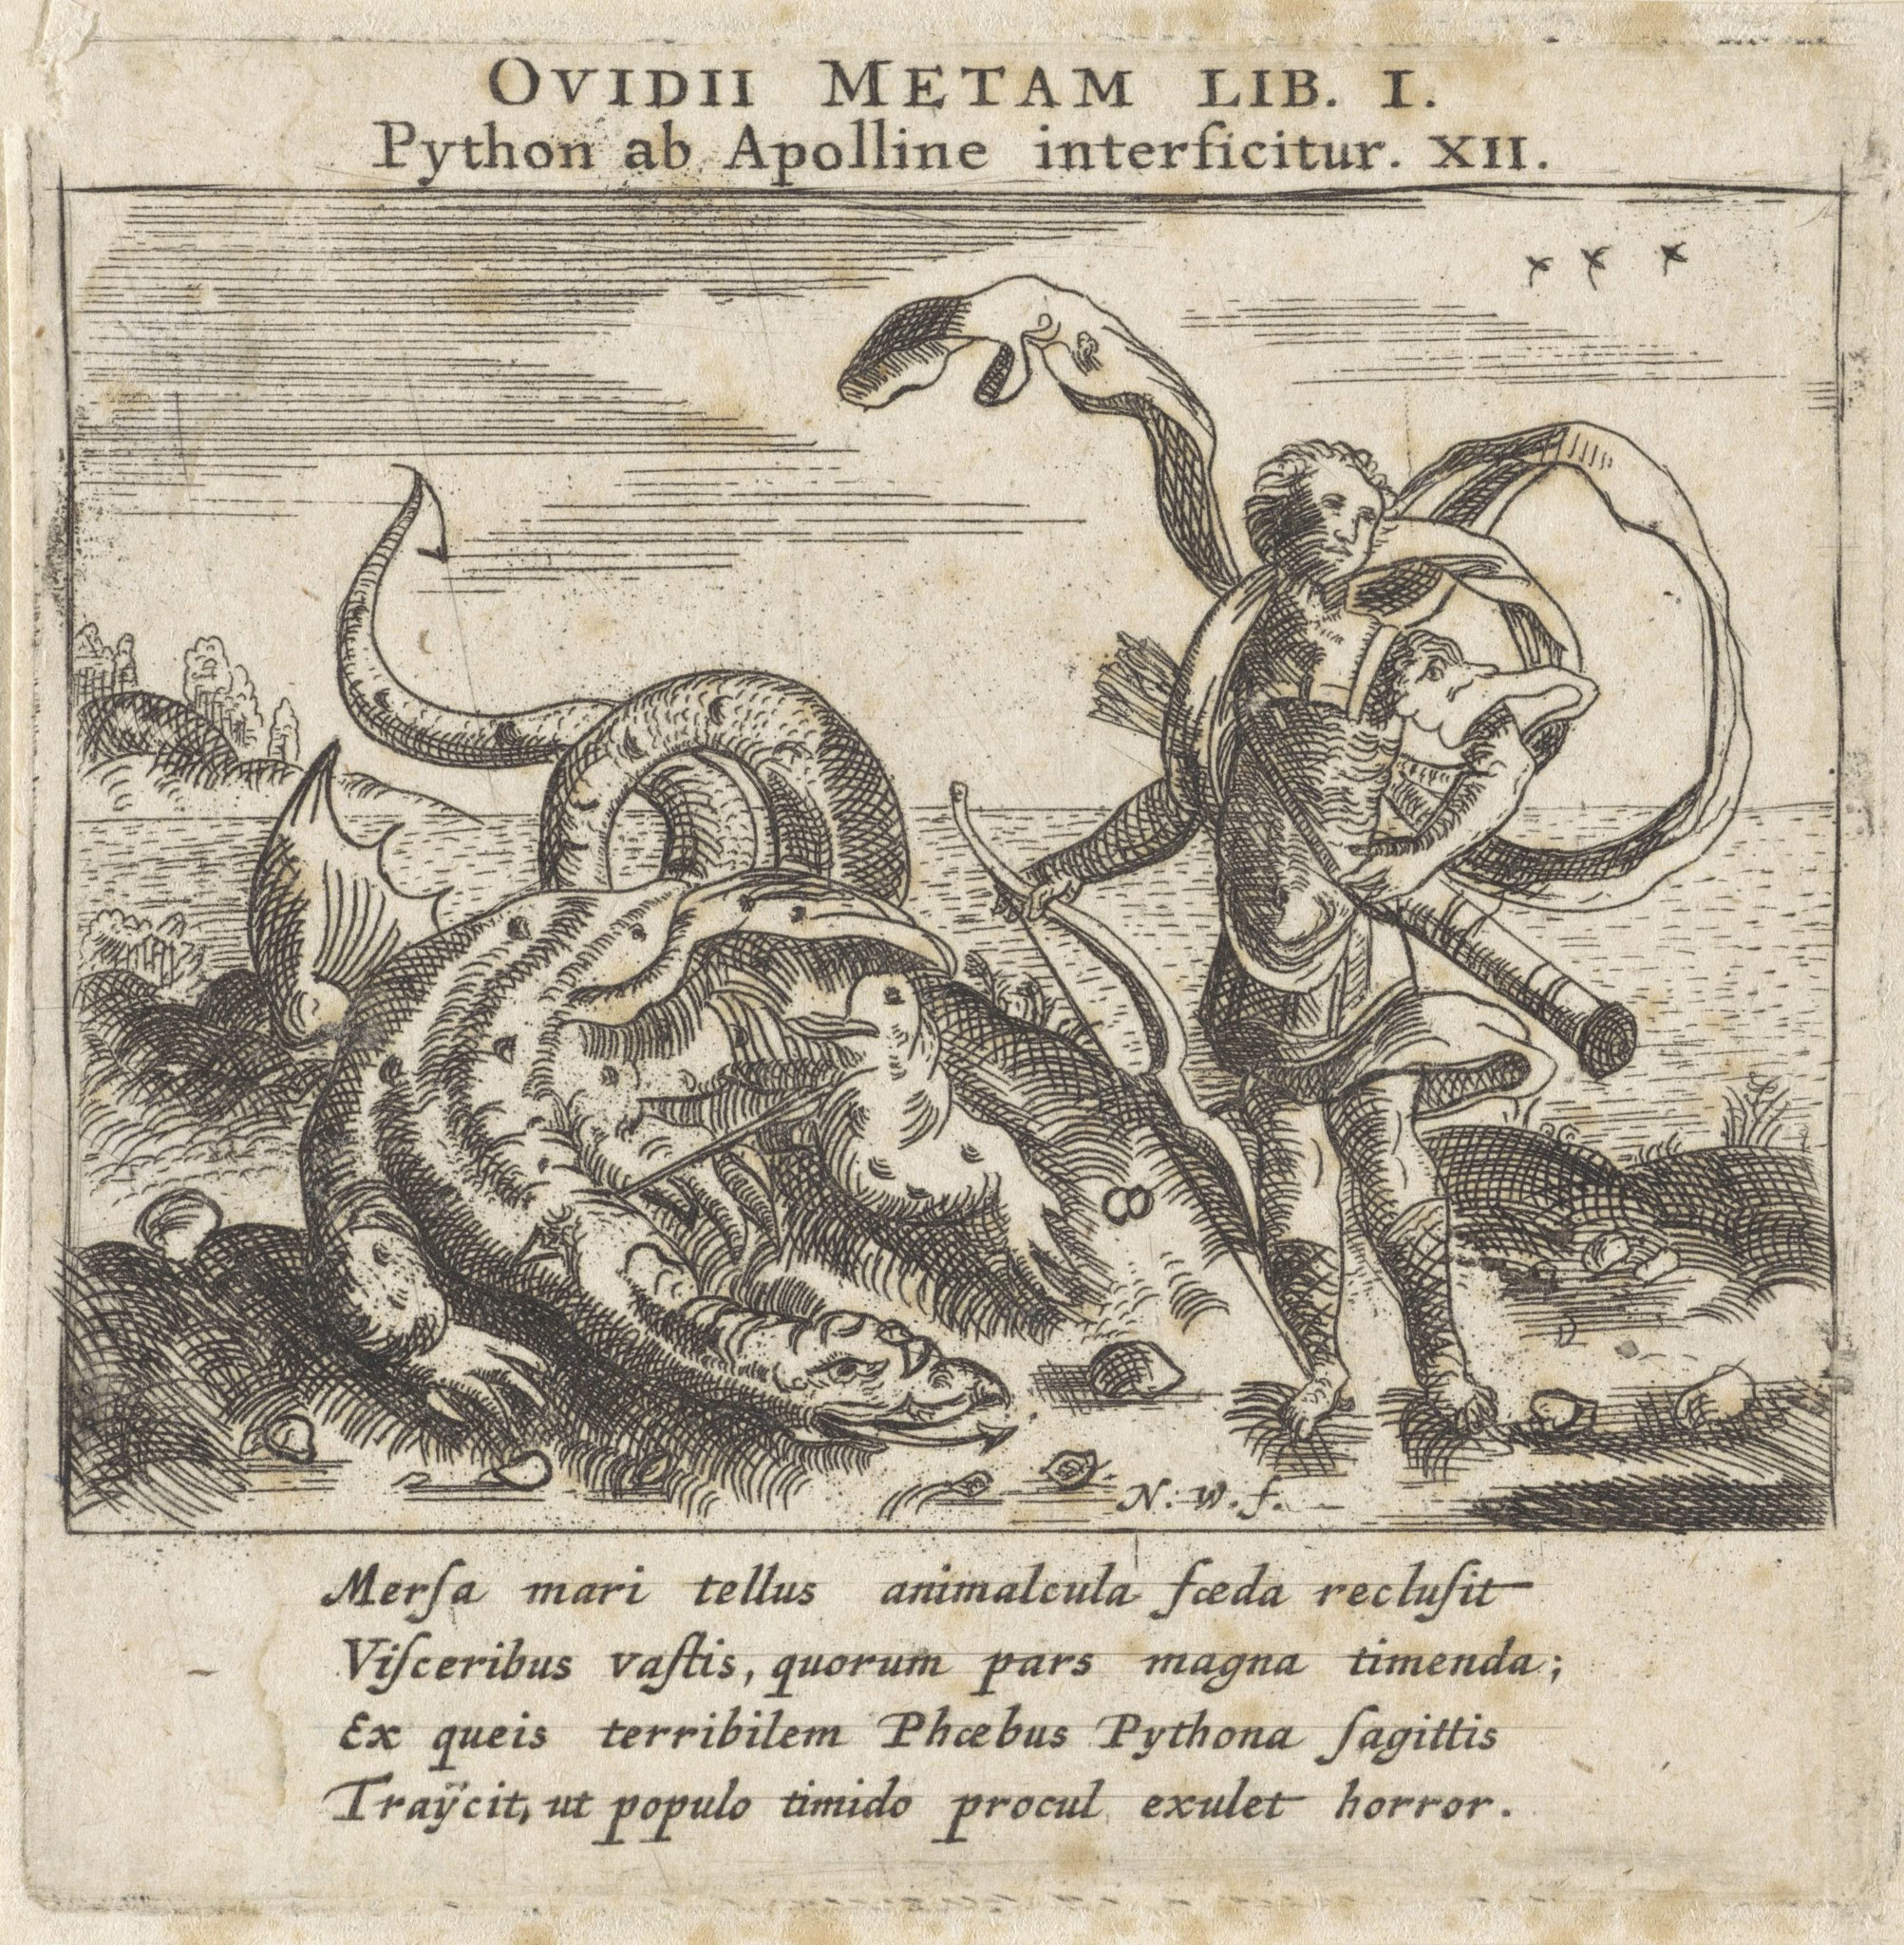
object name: print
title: Metamorphoseos liber primus (...)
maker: nicolaes cornelisz. witsen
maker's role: mayor, print maker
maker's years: 1641-1717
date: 1659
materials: paper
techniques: etching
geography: amsterdam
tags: apollo shoots python, the dragon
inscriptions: collector's mark: Lugt 2165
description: Apollo staat bij de python, die hij met een pijl heeft gedood. Onder de voorstelling een vierregelige toelichting in het Latijn.